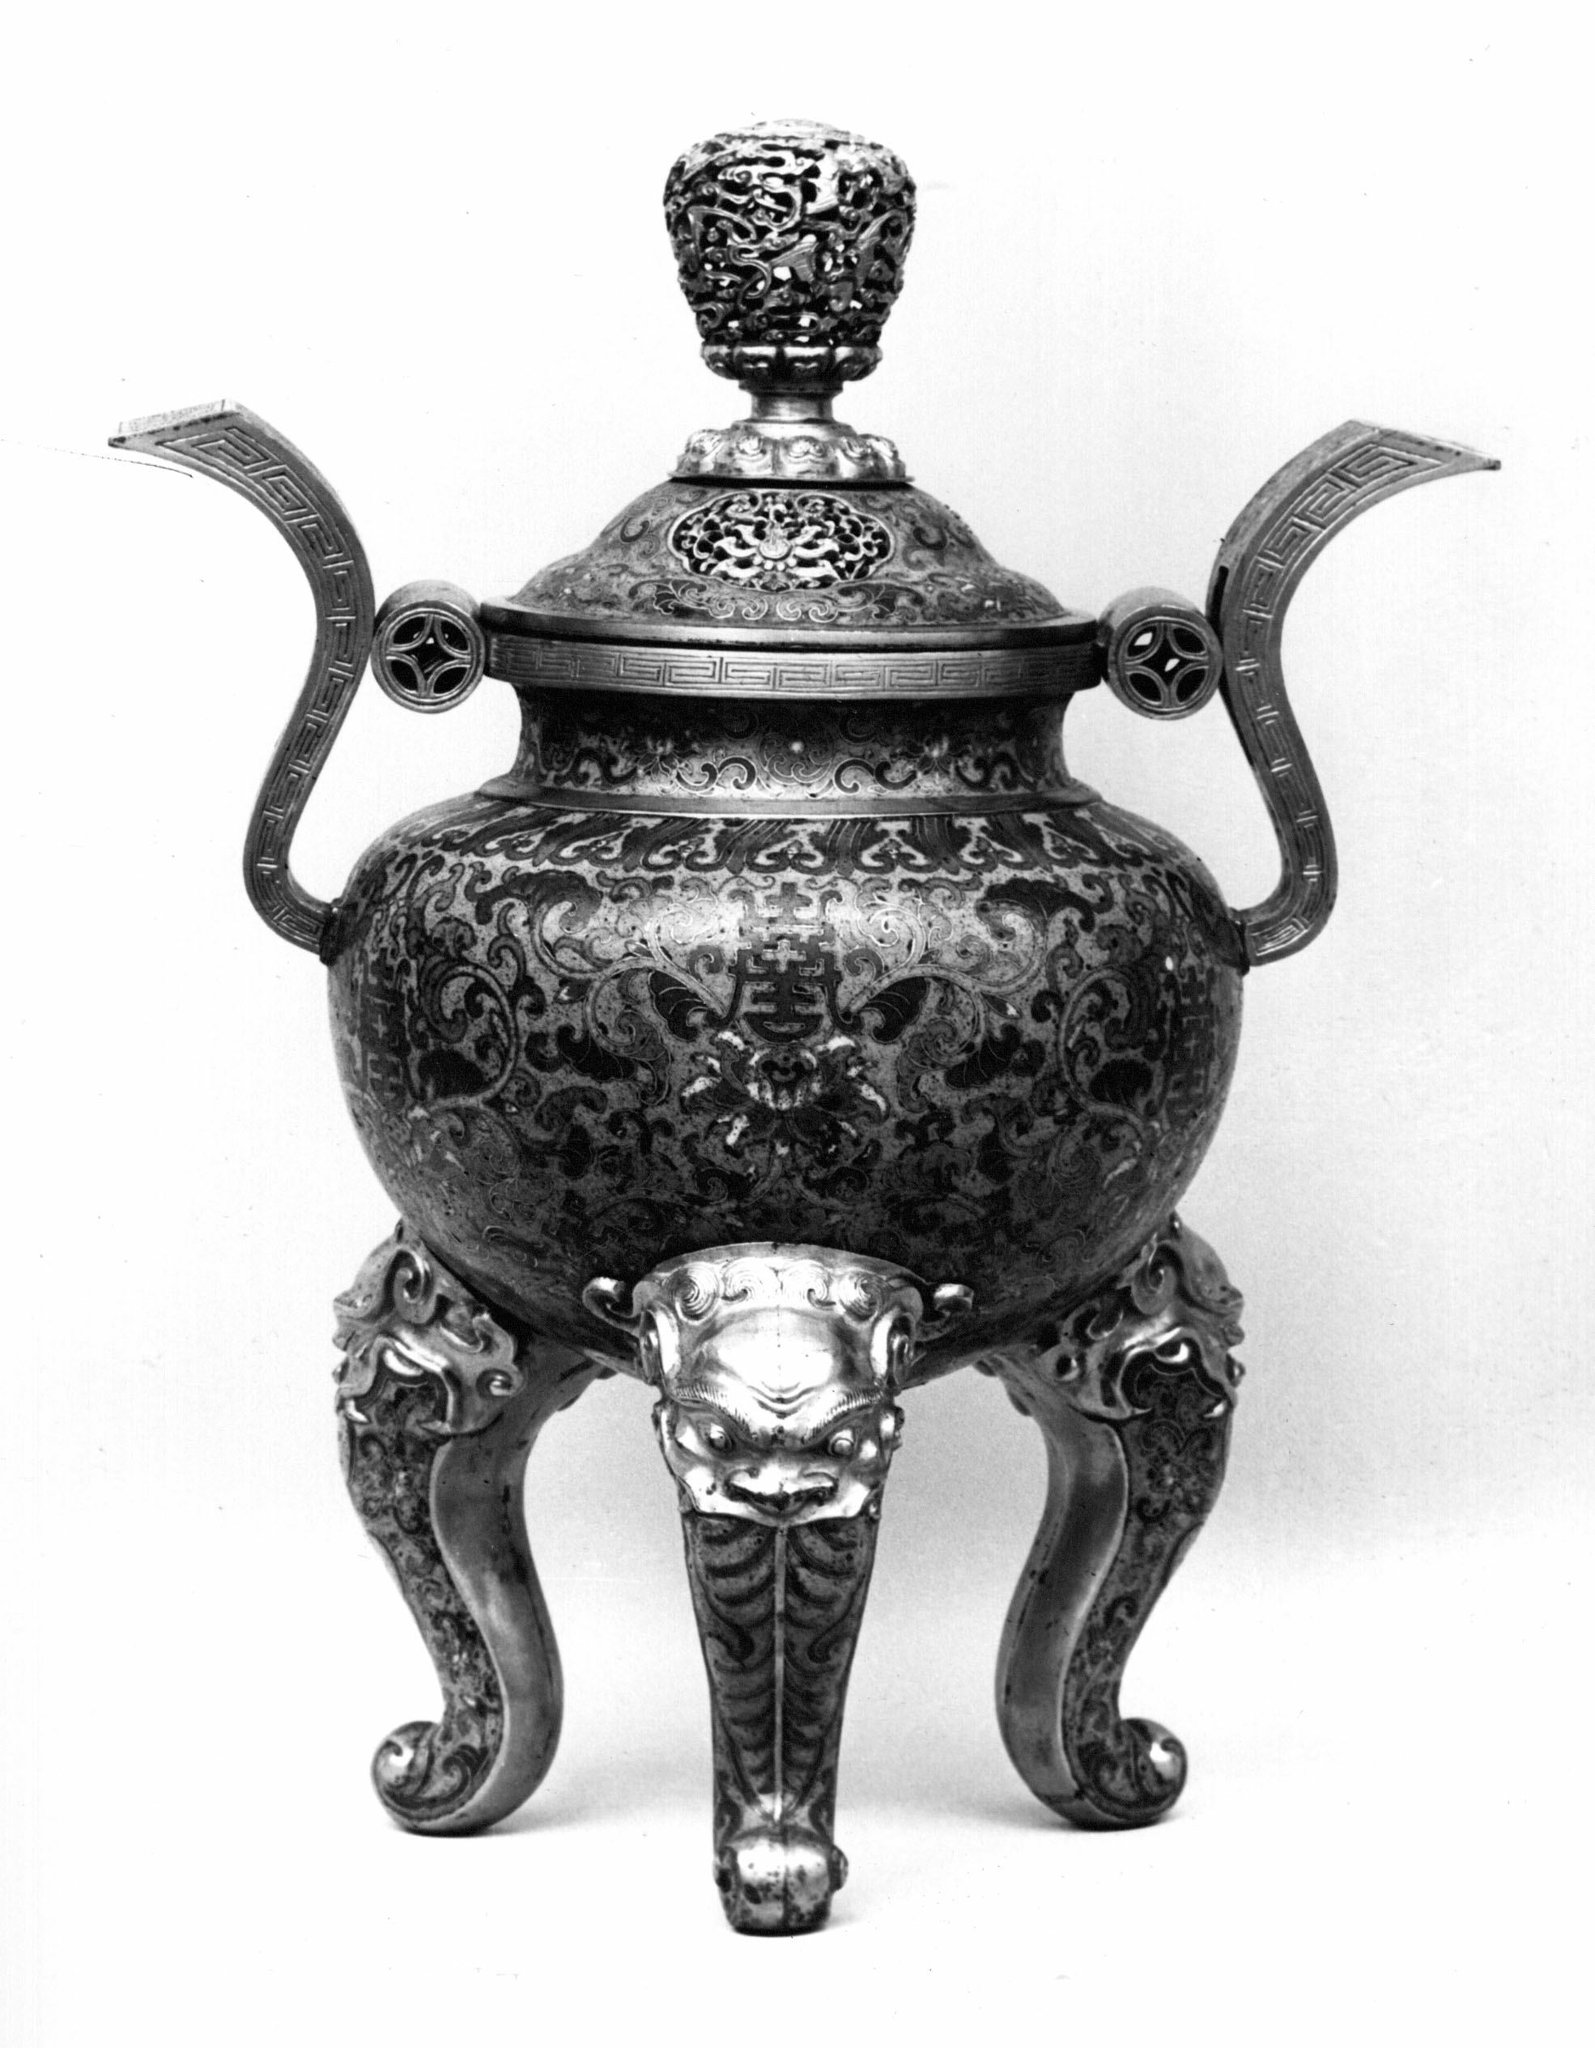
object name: incense burner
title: Incense Burner from a Set of Five-Piece Altar Set (Wugong)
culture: chinese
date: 1736-1795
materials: copper, enamel, gilt bronze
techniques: enamel